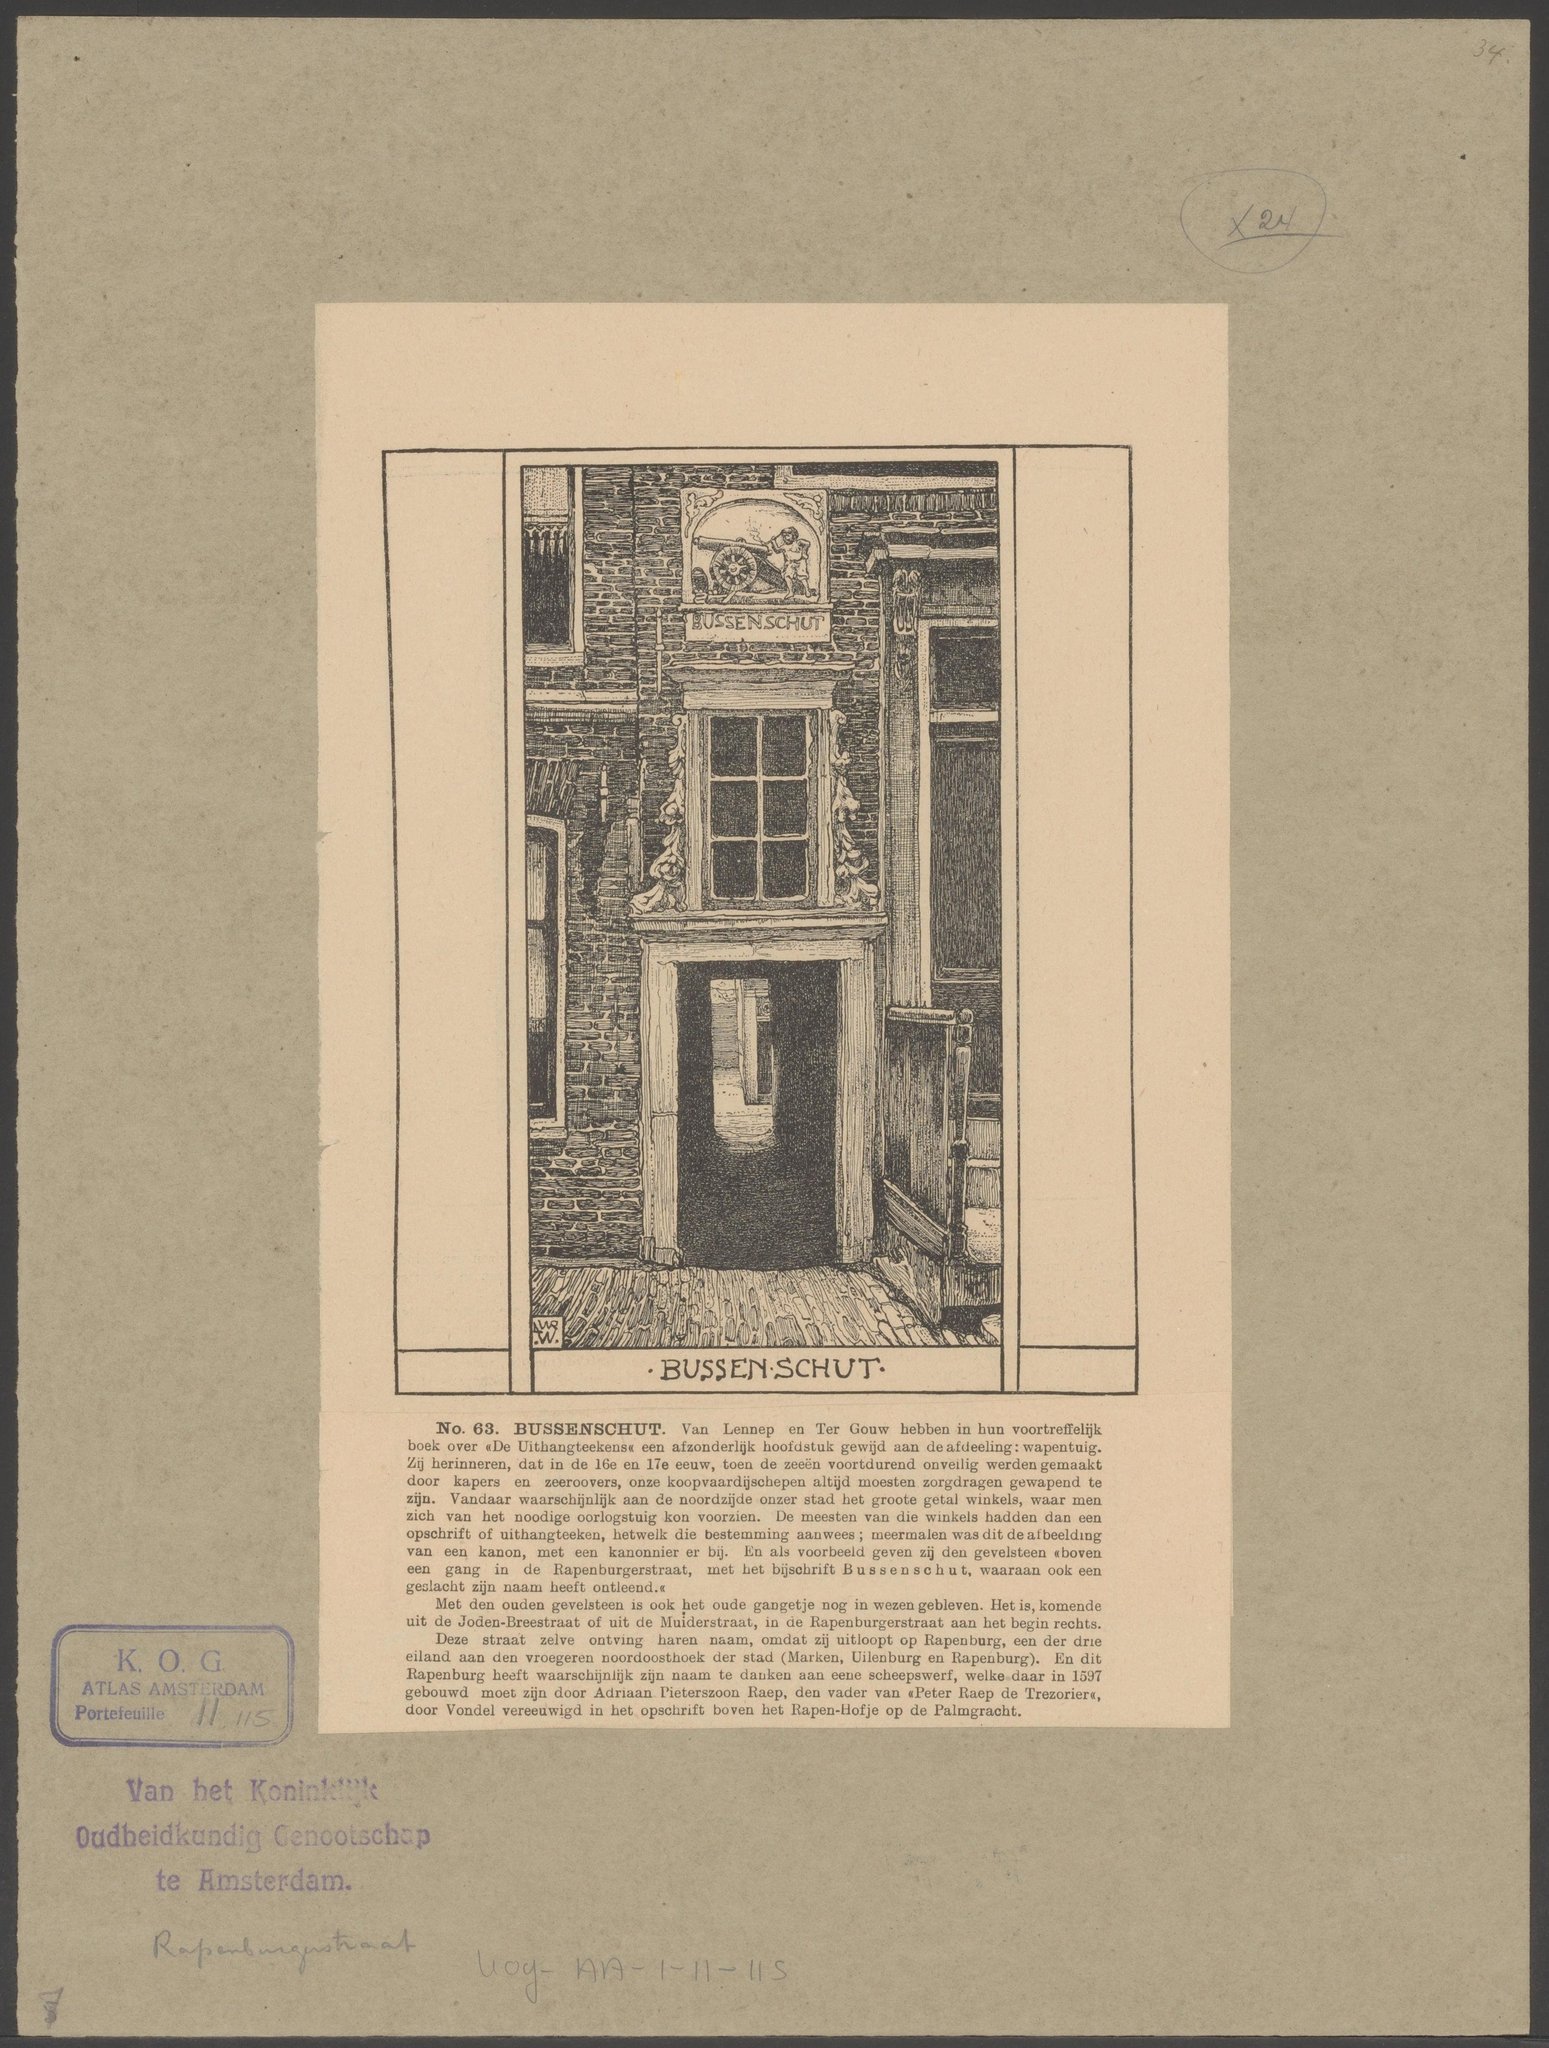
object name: page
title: Oud-Amsterdam 100 Stadsgezichten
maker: willem wenckebach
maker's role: designer, draughtsman, painter, print maker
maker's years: 1860-1937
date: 1870-1923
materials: paper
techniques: letterpress printing, line block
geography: amsterdam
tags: stone tablet in façade, city-view in general; 'veduta', façade (of house or building)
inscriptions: collector's mark: ‘11.115’ Lugt 1641b, stamp: ‘Van het Koninklijk / Oudheidkundig Genootschap / te Amsterdam.’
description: Onderwerpsrubriek binnen de Atlas Amsterdam: Raadhuisstraat, Raamgracht, Raamplein, Rapenburgerstraat, Reguliersgracht, Reguliersbreestraat.